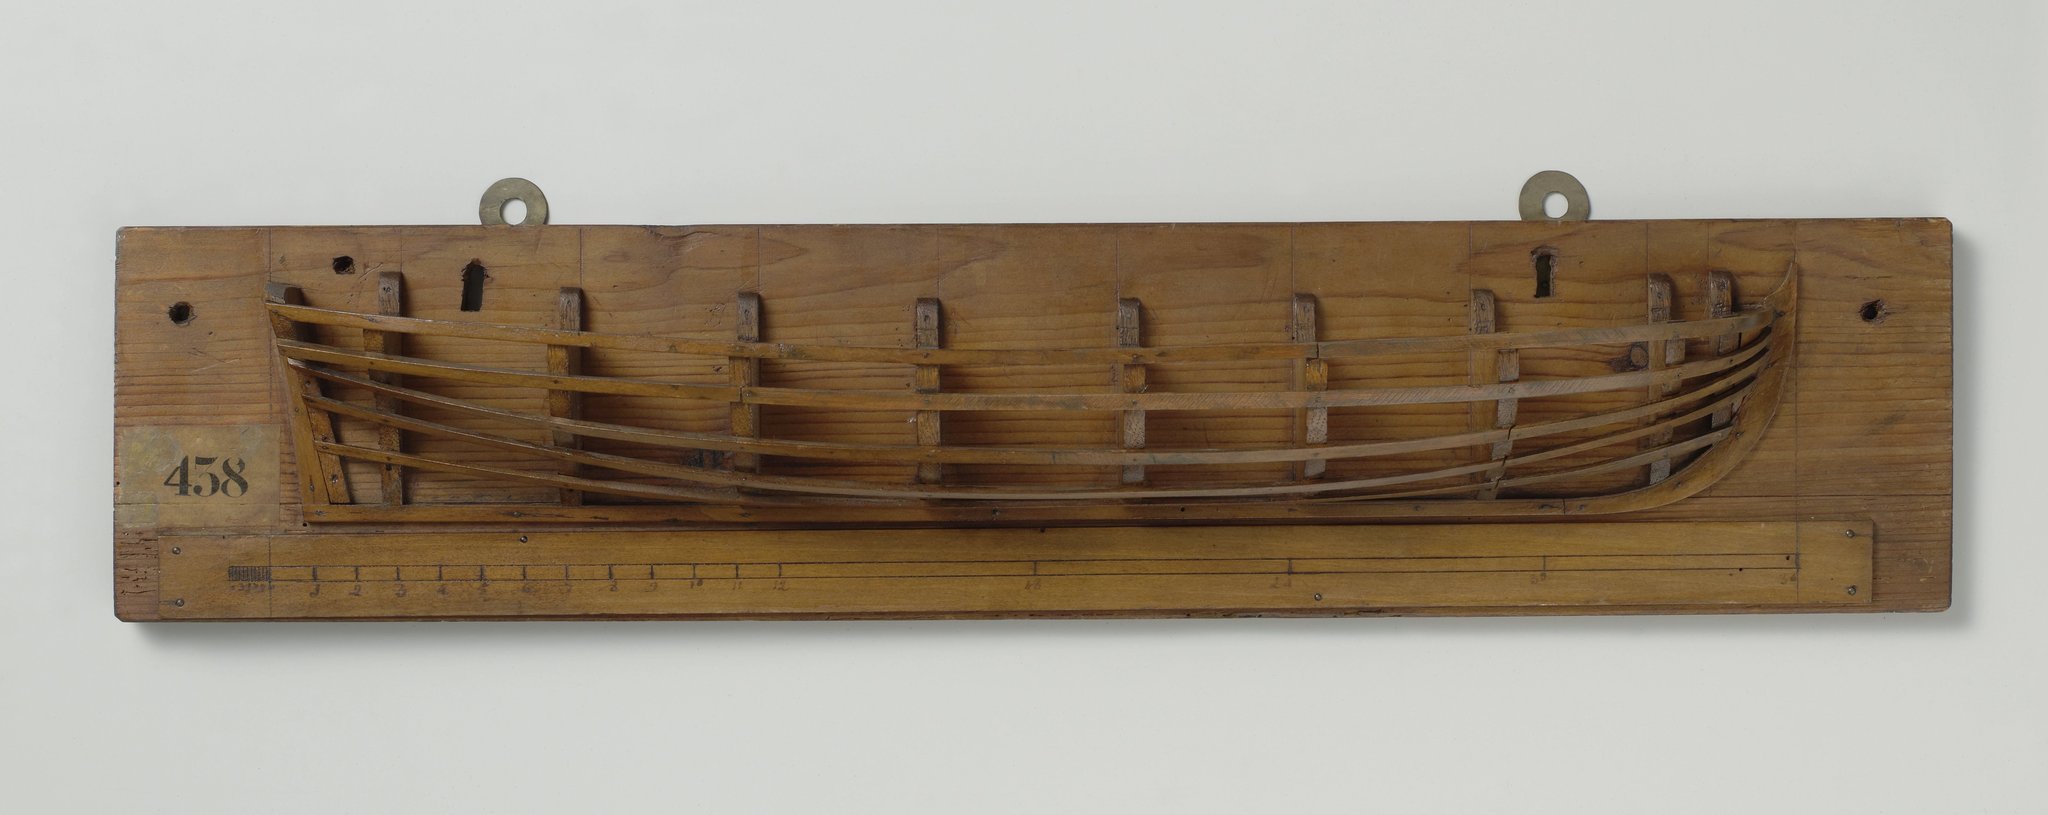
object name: builder's model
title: Half Model of a Launch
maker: Anonymous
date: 1780-1820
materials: wood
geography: netherlands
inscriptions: label, bottom left: ‘438’ former inventory label, scale, bottom centre: wooden scale in Amsterdam feet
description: Mallenmodel (stuurboord) van een sloep. Platte spiegel. De zeeg loopt op naar beide uiteinden. Rondspant. Schaal ca. 1:22 (schaal op model). Volgens de schaal is deze jol 36 Amsterdamse voeten lang.